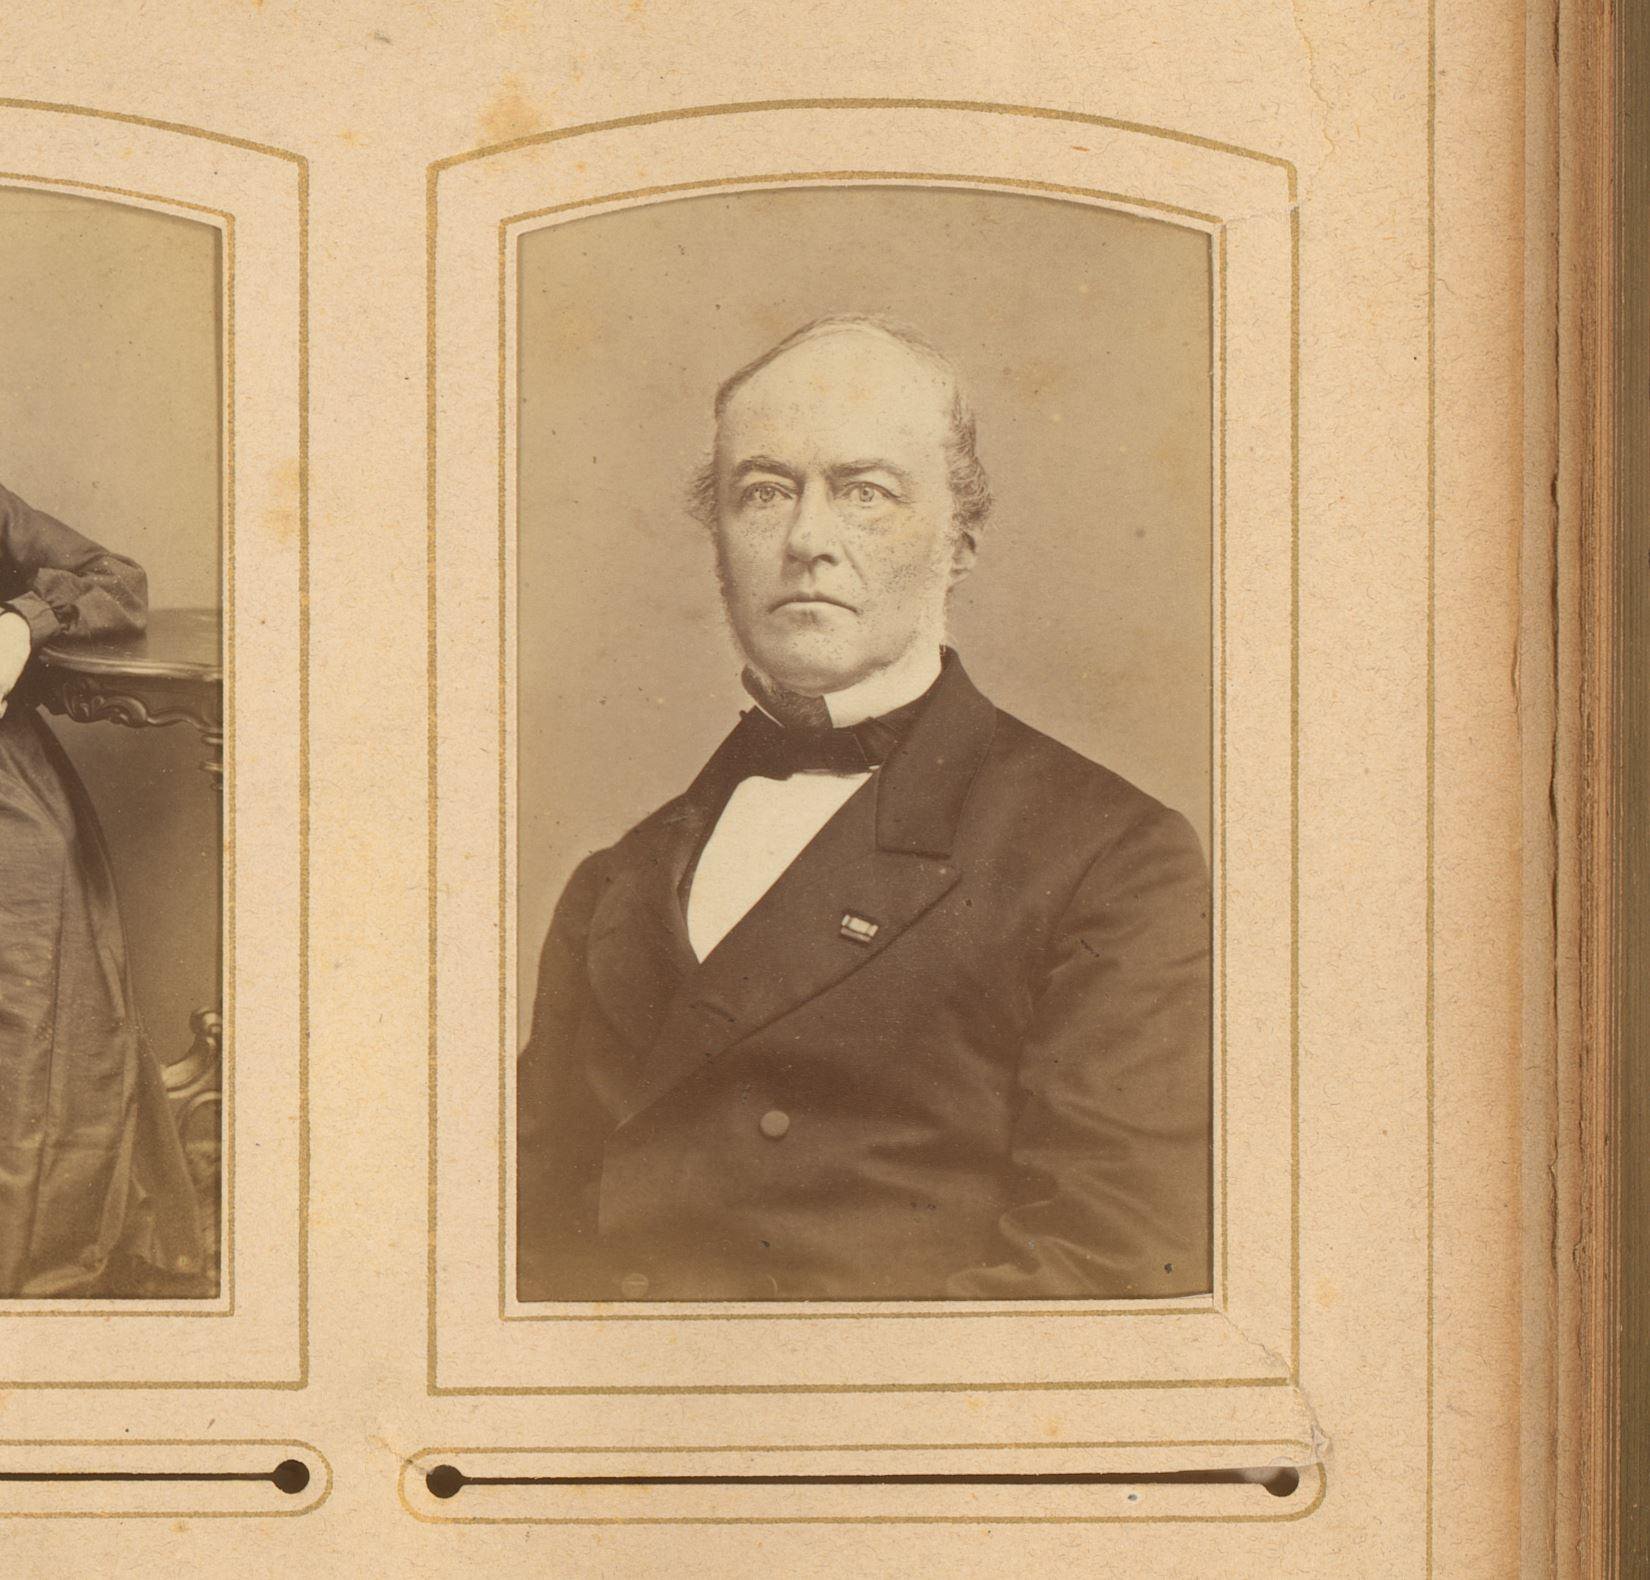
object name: photograph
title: Portret van een man met vlinderstrik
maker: johannes petrus oppers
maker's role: fotograaf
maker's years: 1833-1890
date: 1869-1890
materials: cardboard, photographic support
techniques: albumen print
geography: amsterdam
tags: historical persons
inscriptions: inscription: ‘J. P. Oppens/ Photograaf/ van zyne/ Majesteit den Koning/ der Nederlanden/ Kalverstraat E. 55/ AMSTERDAM.’